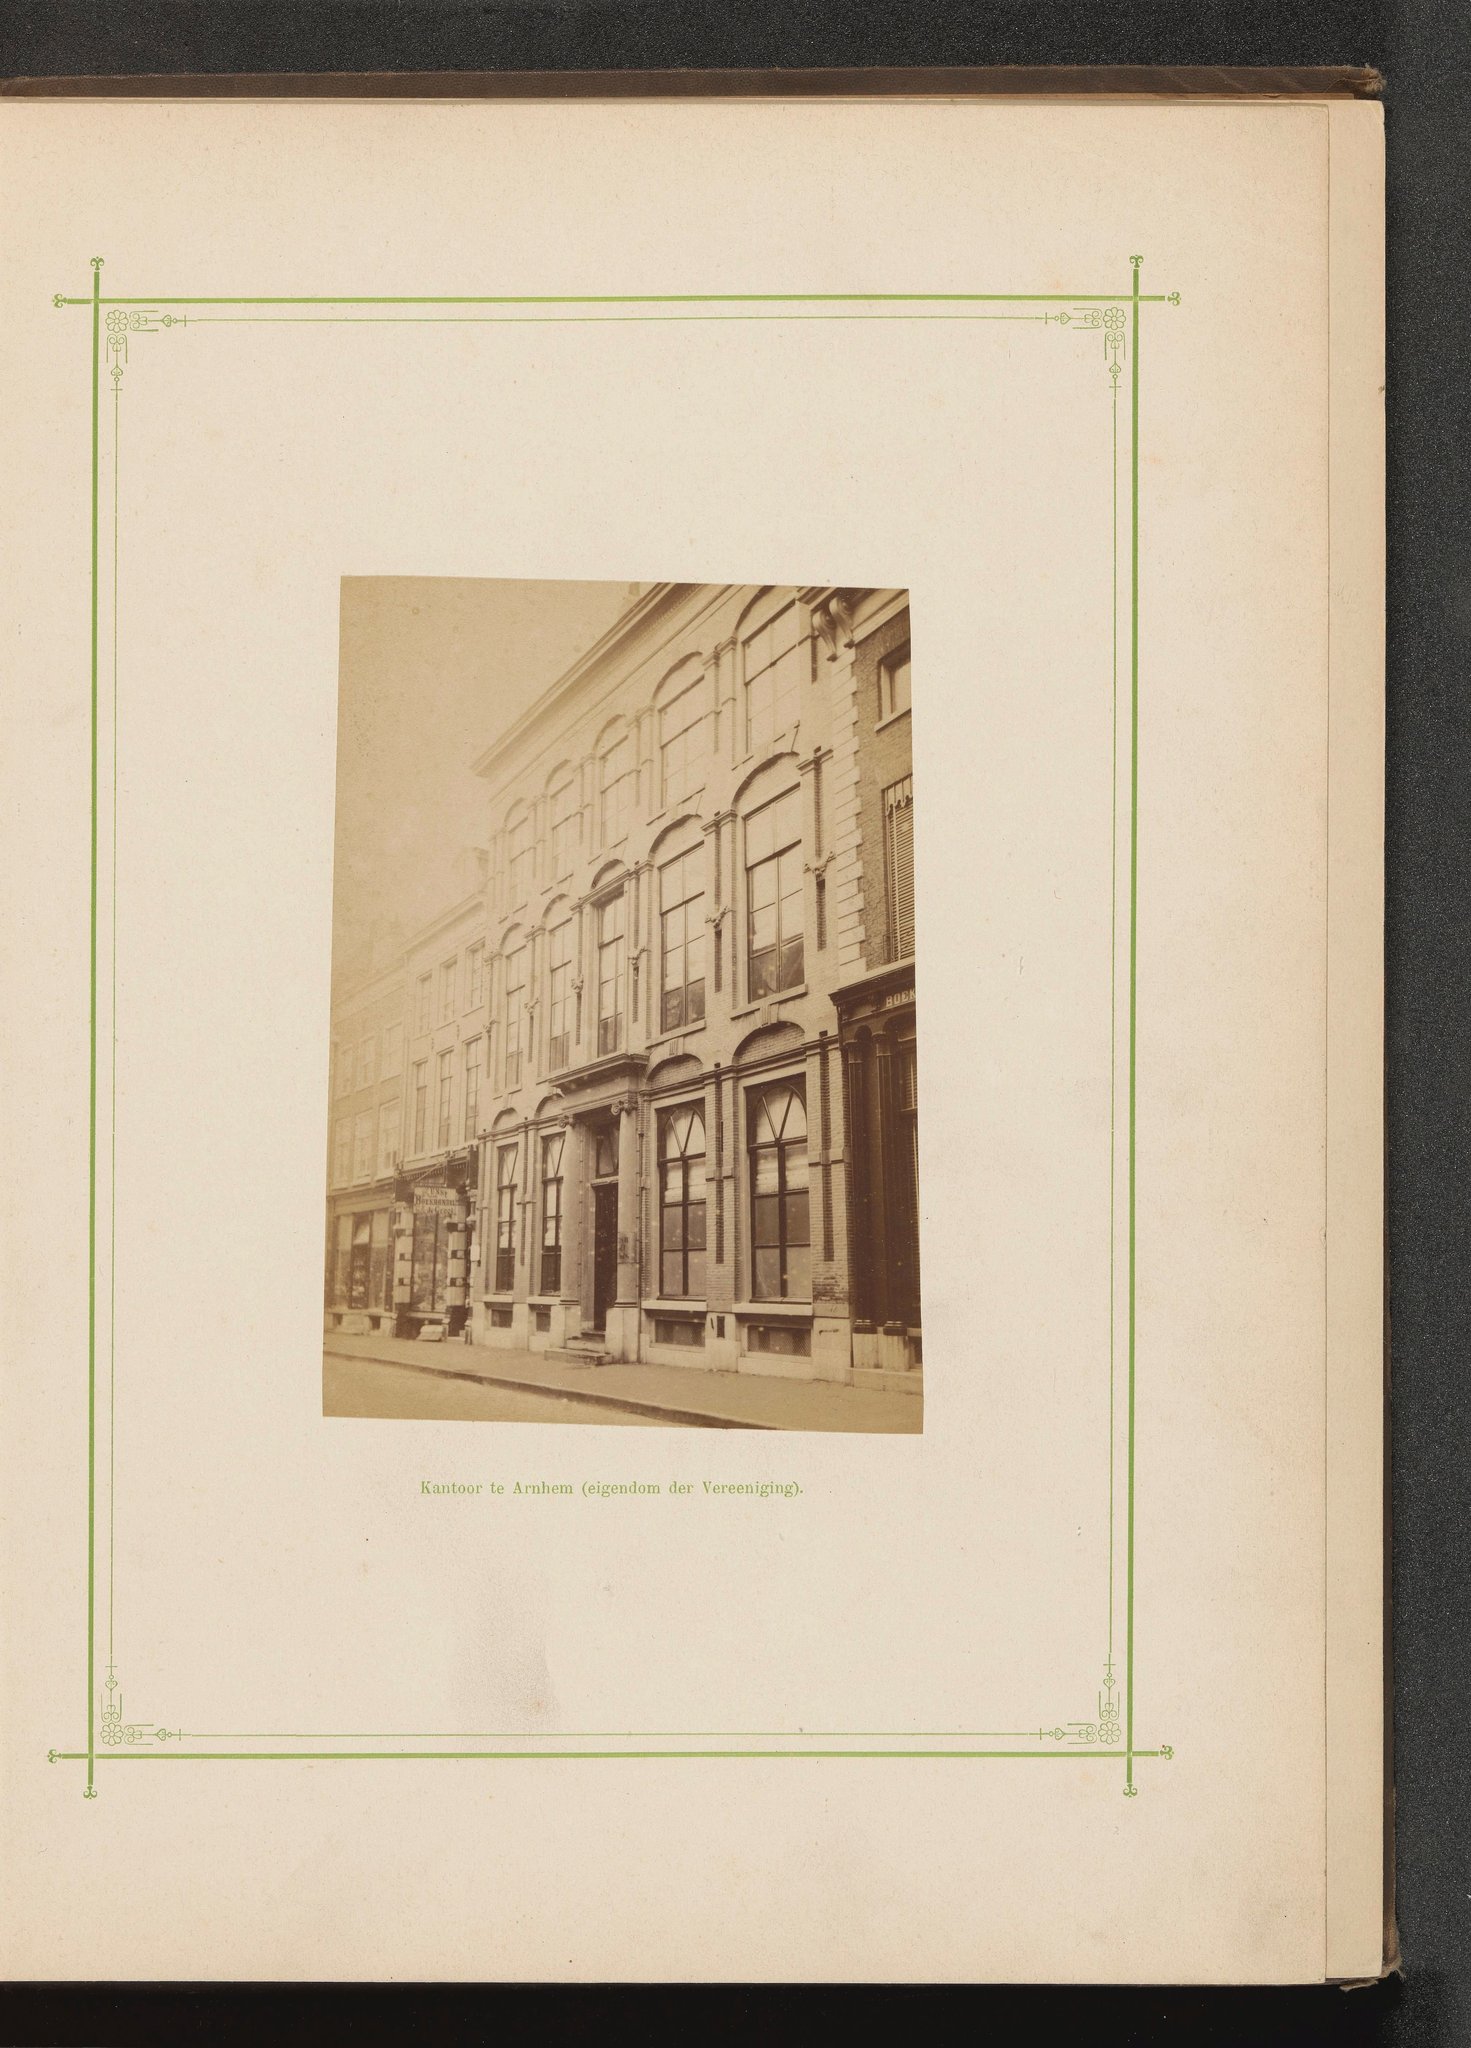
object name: page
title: Gezicht op het kantoor van de Geldersche Crediet-Vereeniging in Arnhem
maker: Anonymous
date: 1891-1892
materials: photographic support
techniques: albumen print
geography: arnhem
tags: façade (of house or building), arnhem